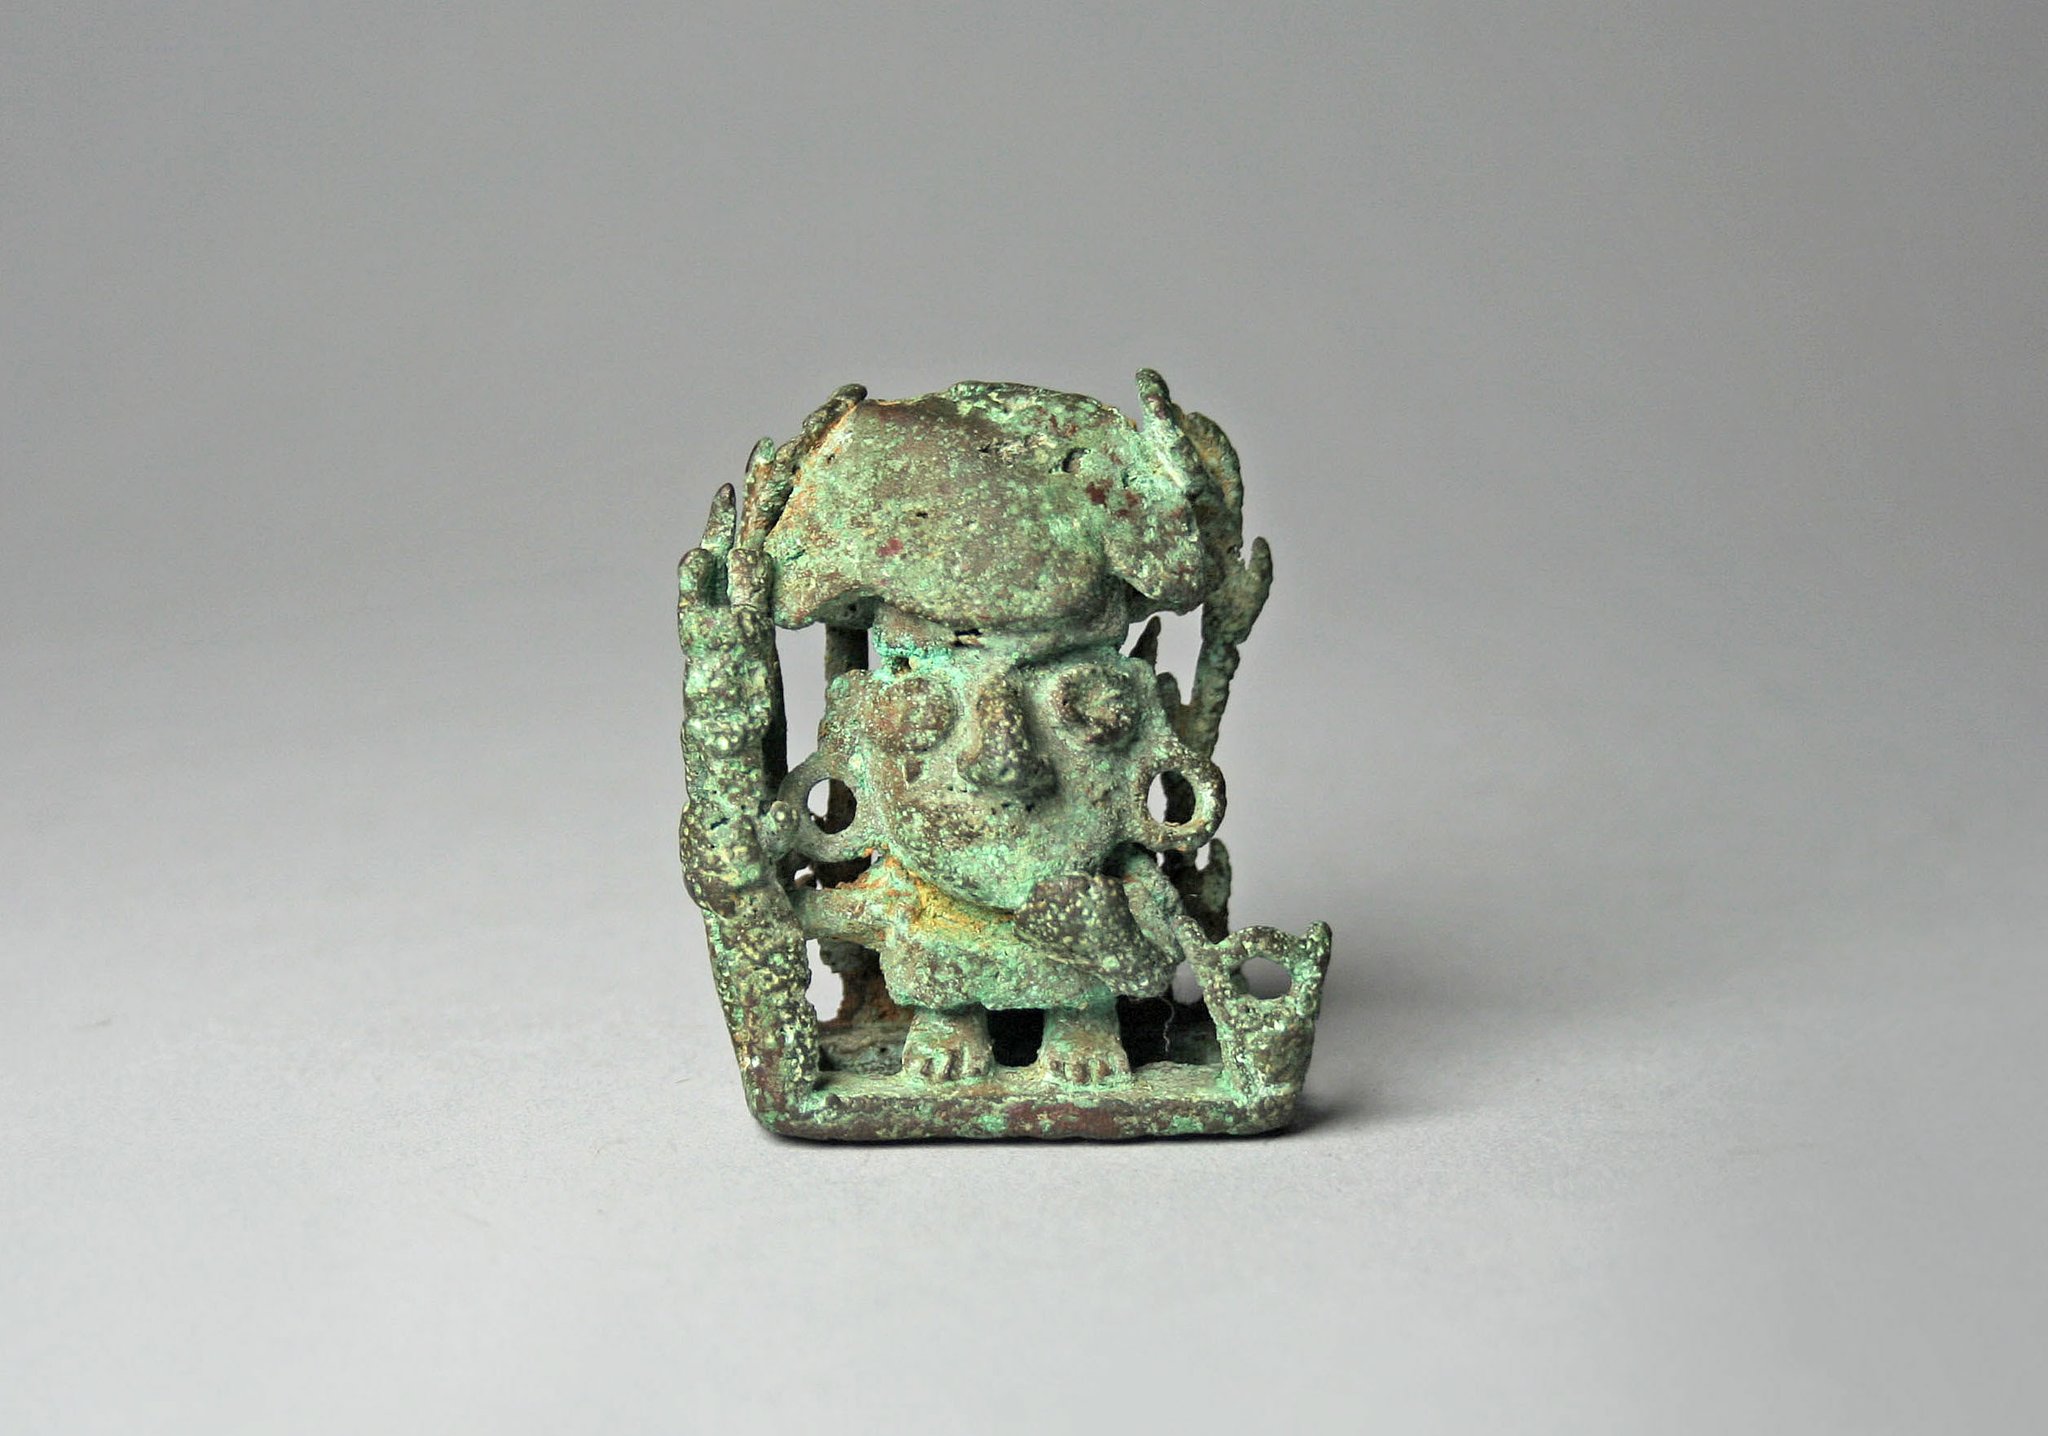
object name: finial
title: Finial with Figure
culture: moche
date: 101-700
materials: bronze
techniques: casting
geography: peru